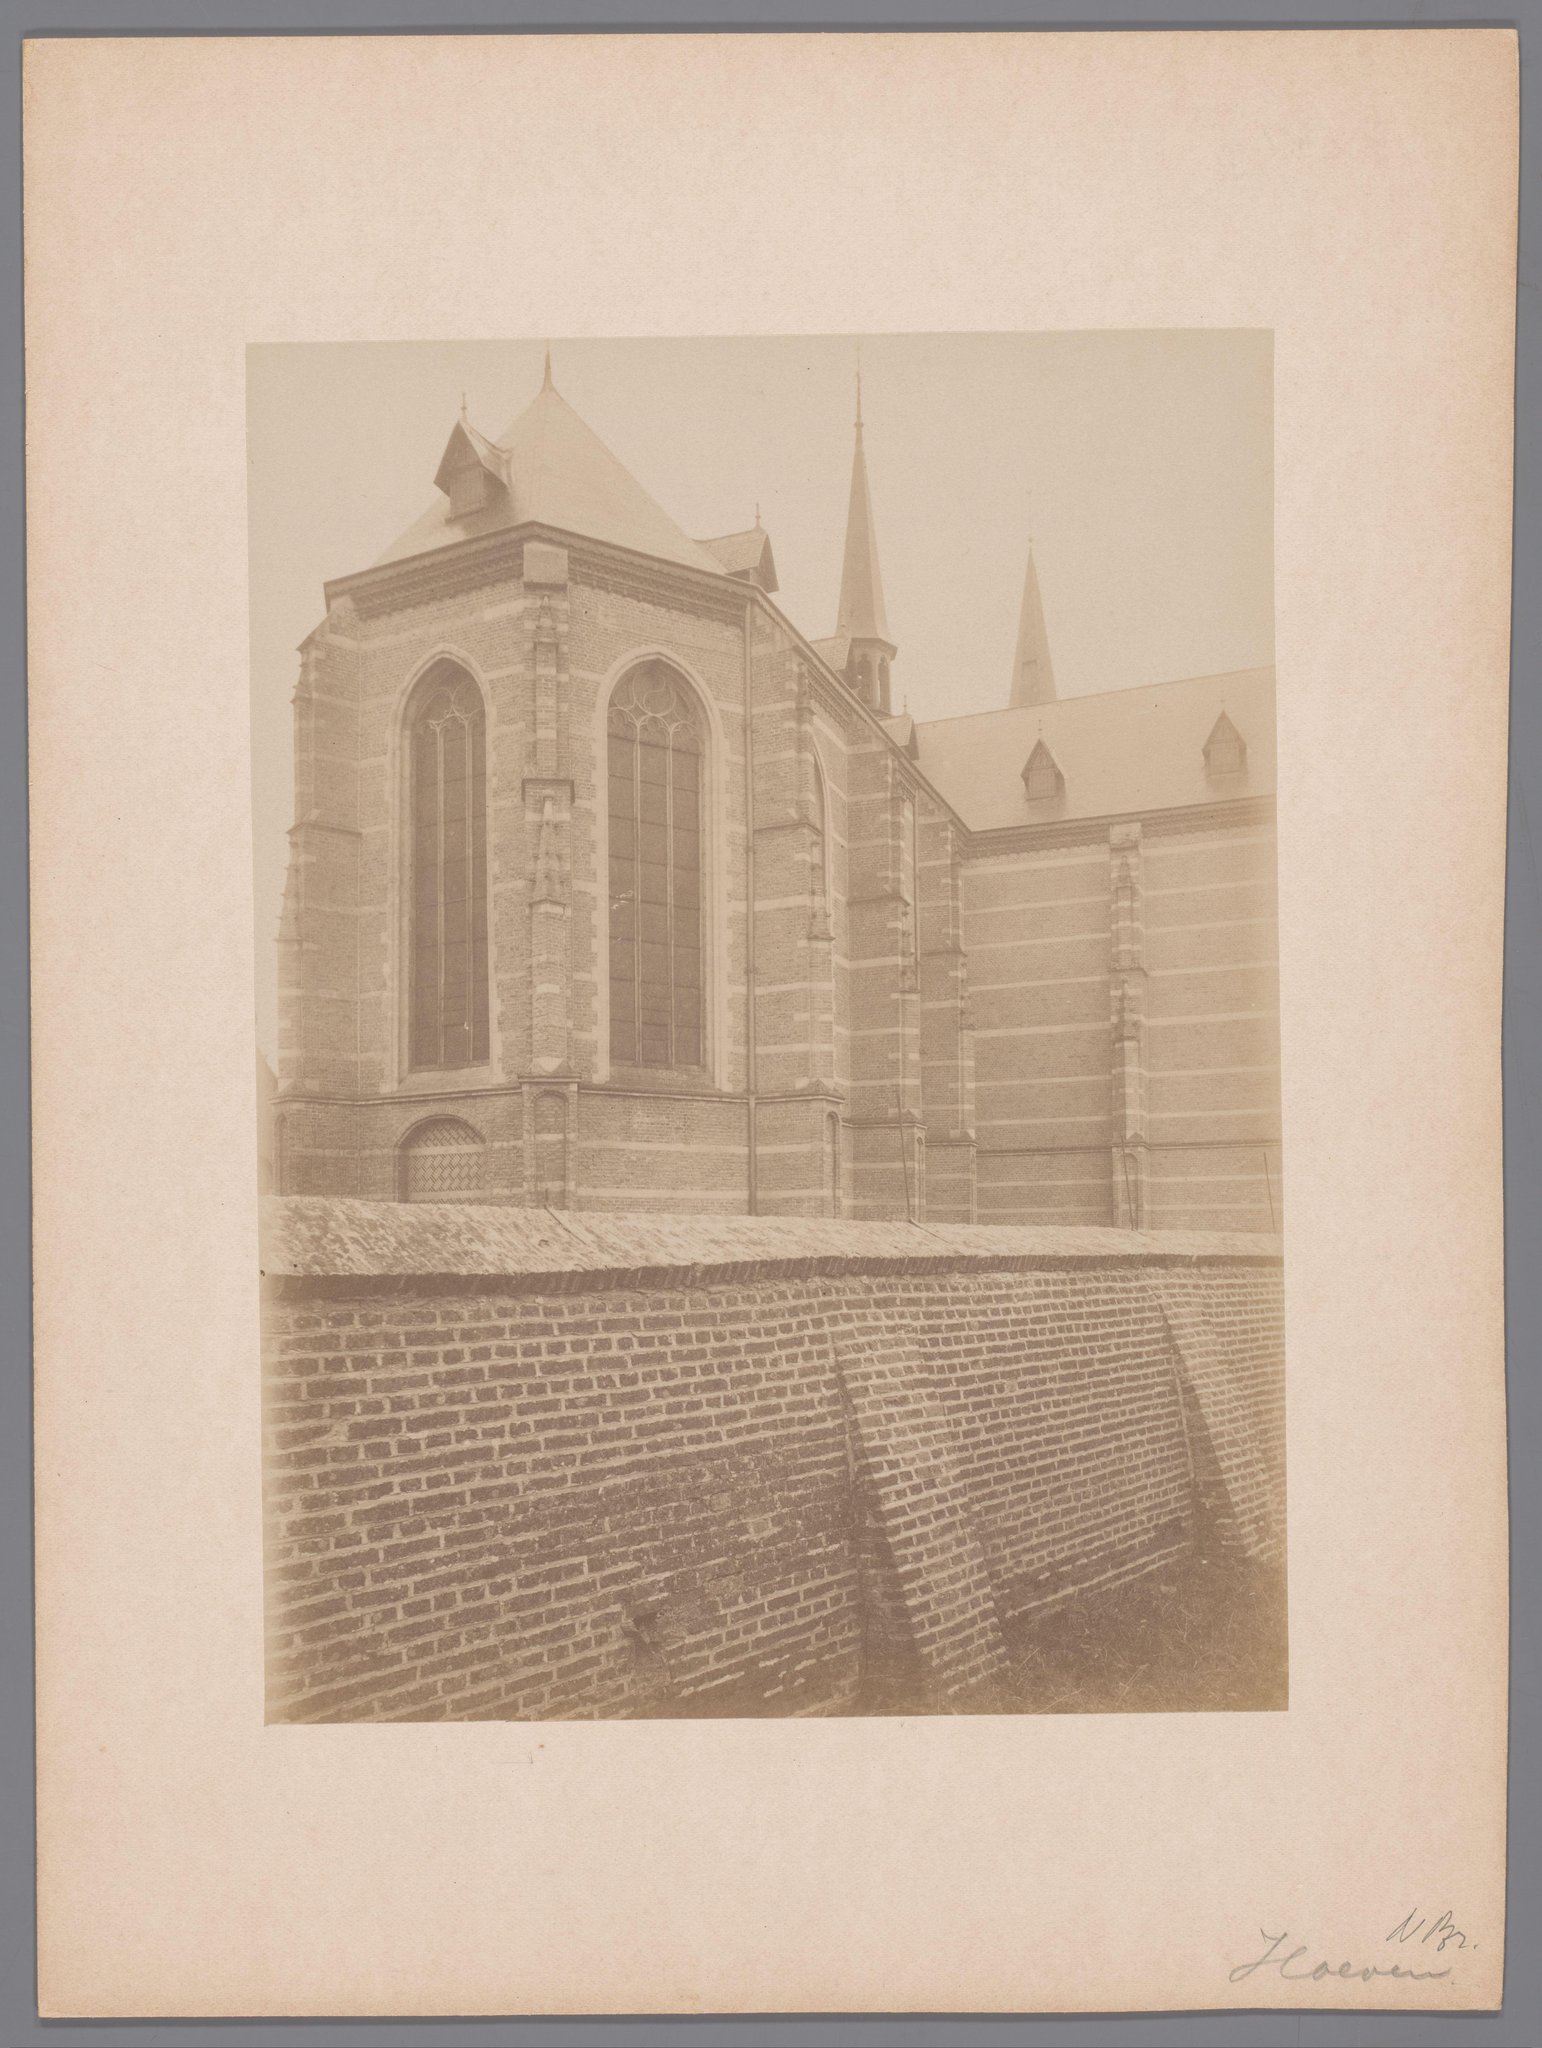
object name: photograph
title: Gedeelte van de rooms-katholieke kerk te Hoeven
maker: anoniem (monumentenzorg)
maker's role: fotograaf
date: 1904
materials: cardboard, photographic support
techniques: albumen print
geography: hoeven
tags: church (exterior)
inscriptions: annotation: ‘Kerk Hoeven (N.B.)/ oct 1904’, annotation: ‘N.Br. Hoeven’